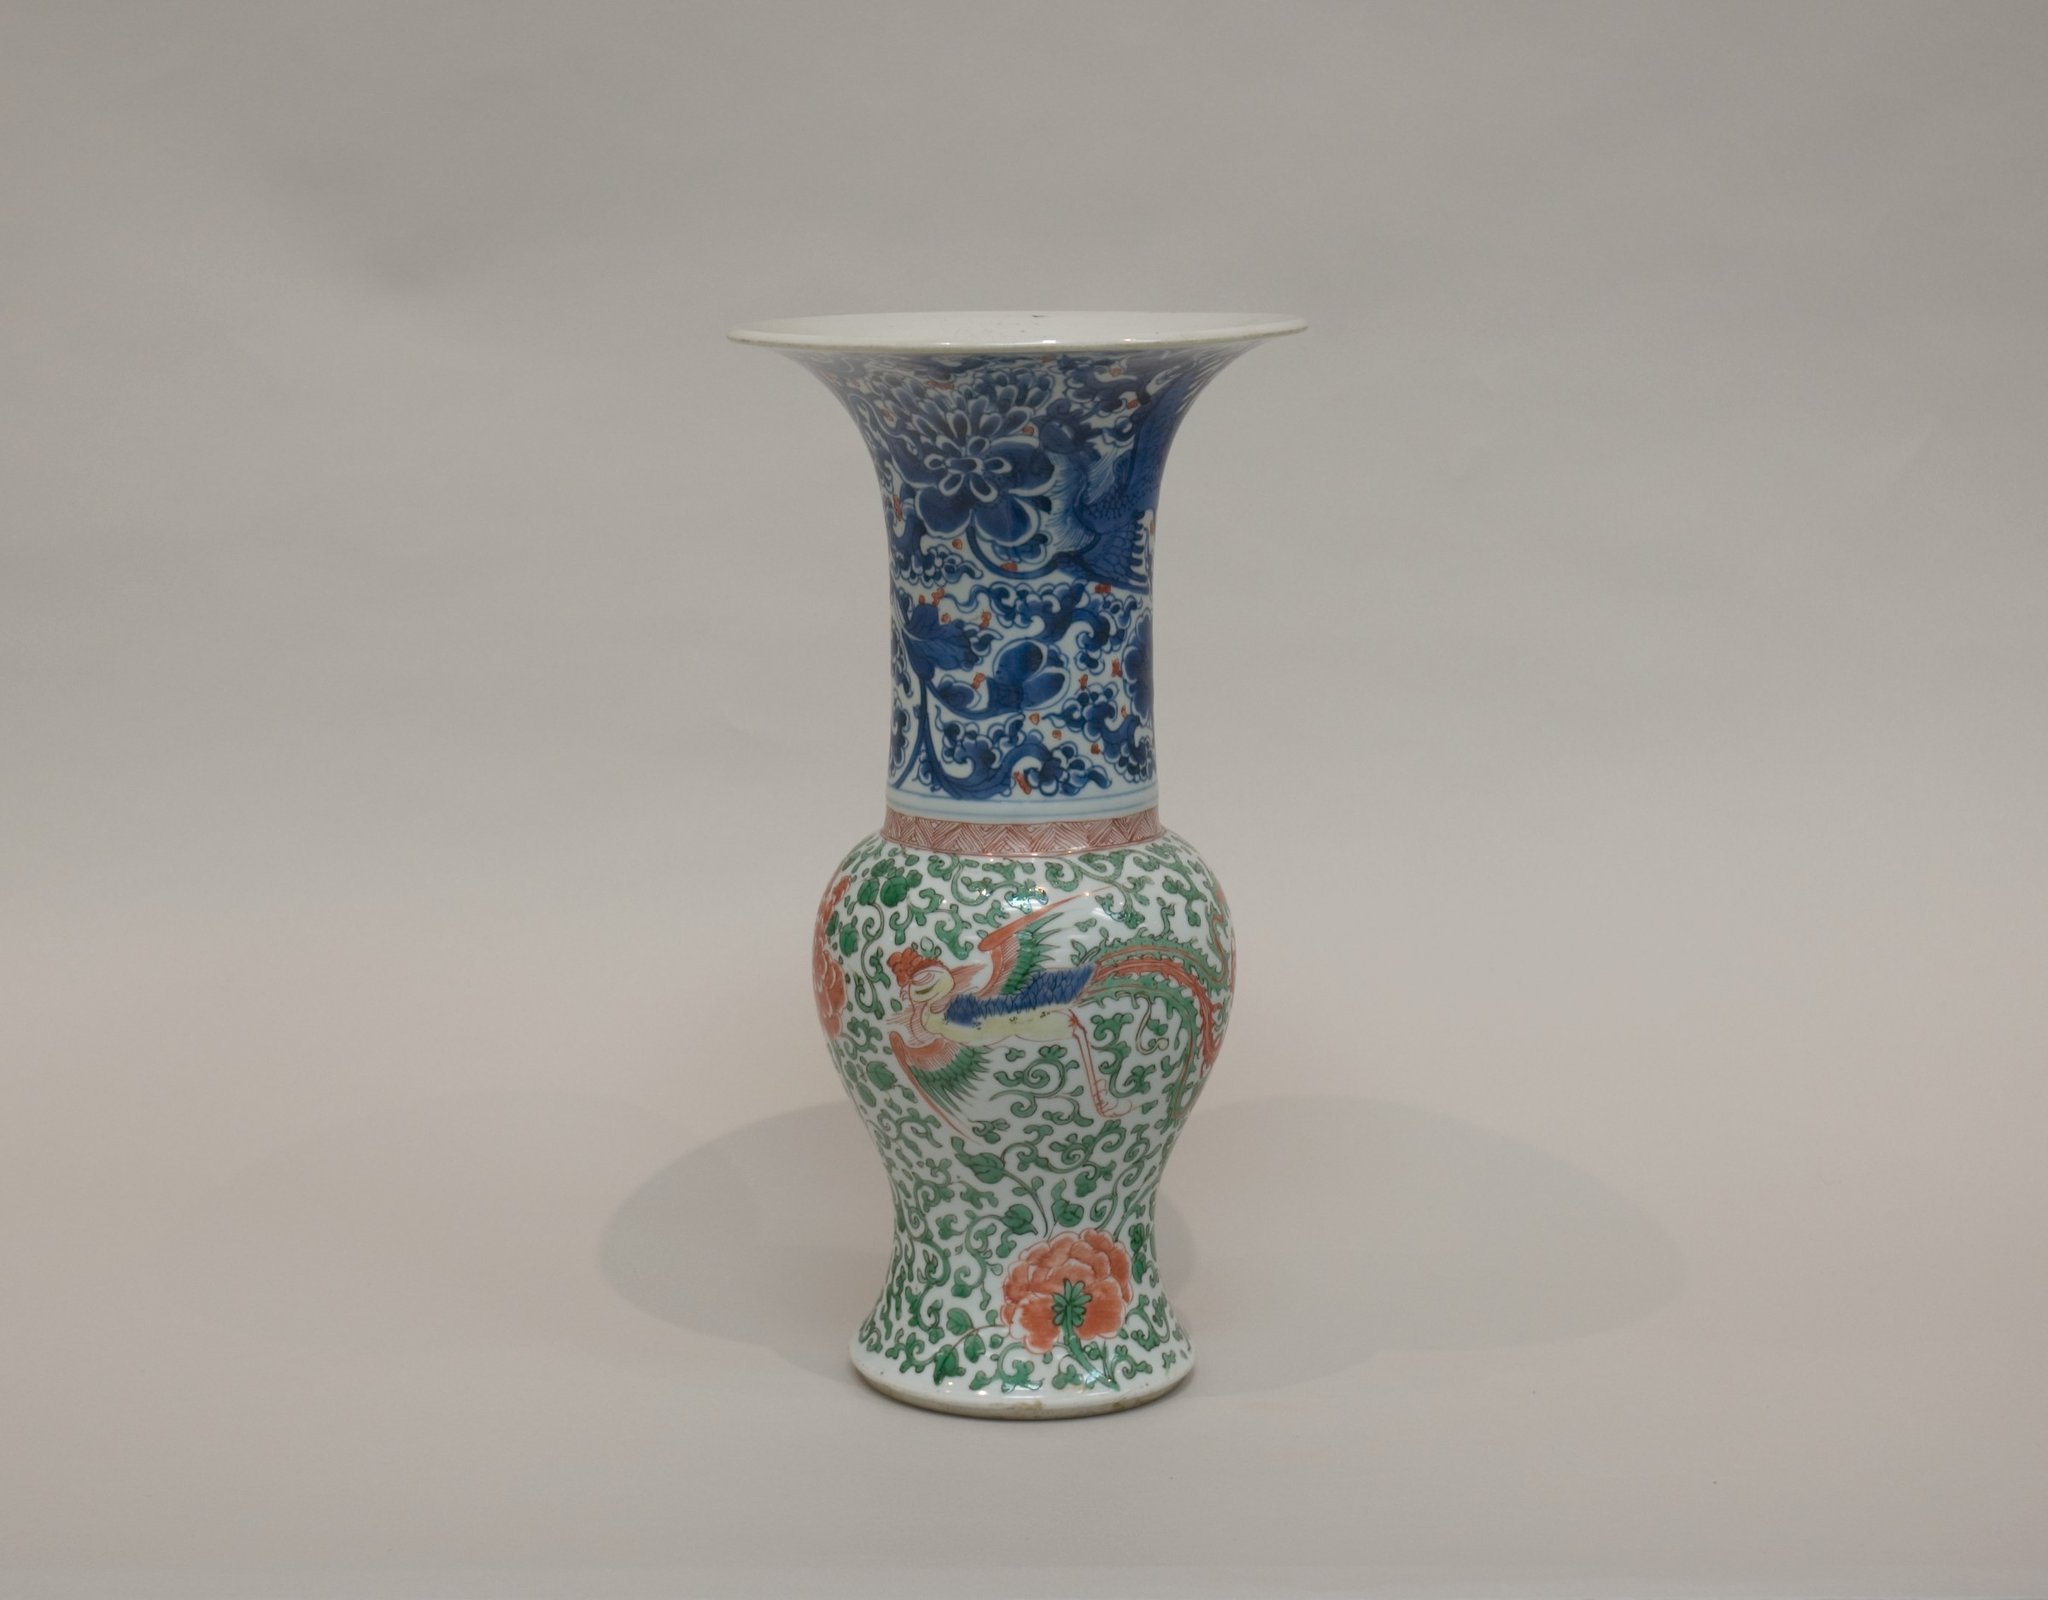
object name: vase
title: Vase with phoenixes amid flowers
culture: chinese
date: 1667-1733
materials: cobalt, enamel, porcelain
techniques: overglaze, painting, polychrome, underglaze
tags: phoenix,flowers